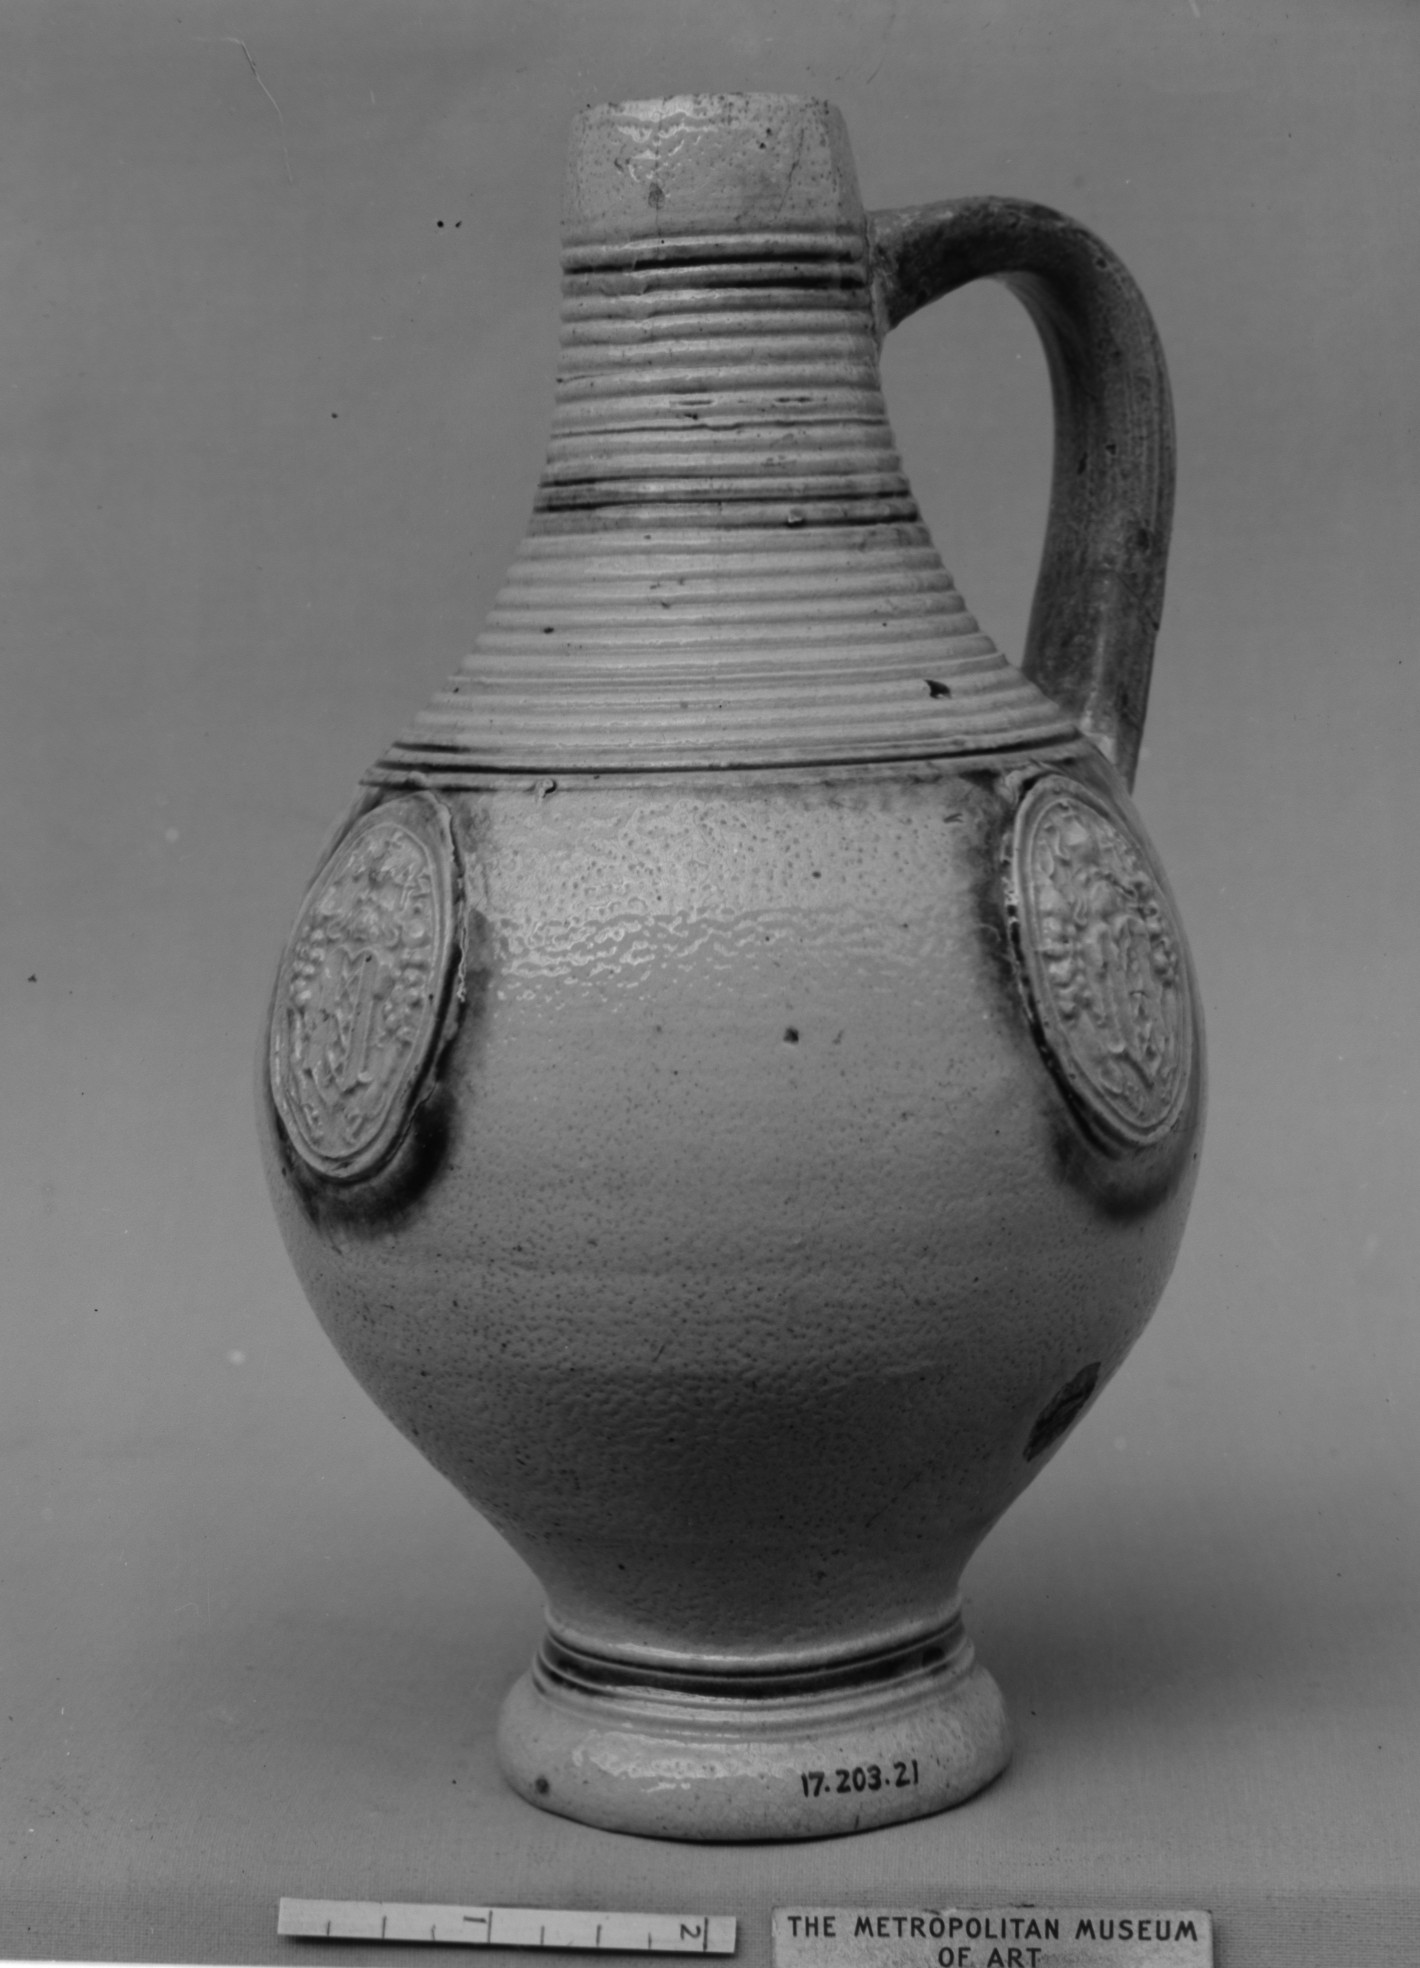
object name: jug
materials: stoneware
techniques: salt glaze